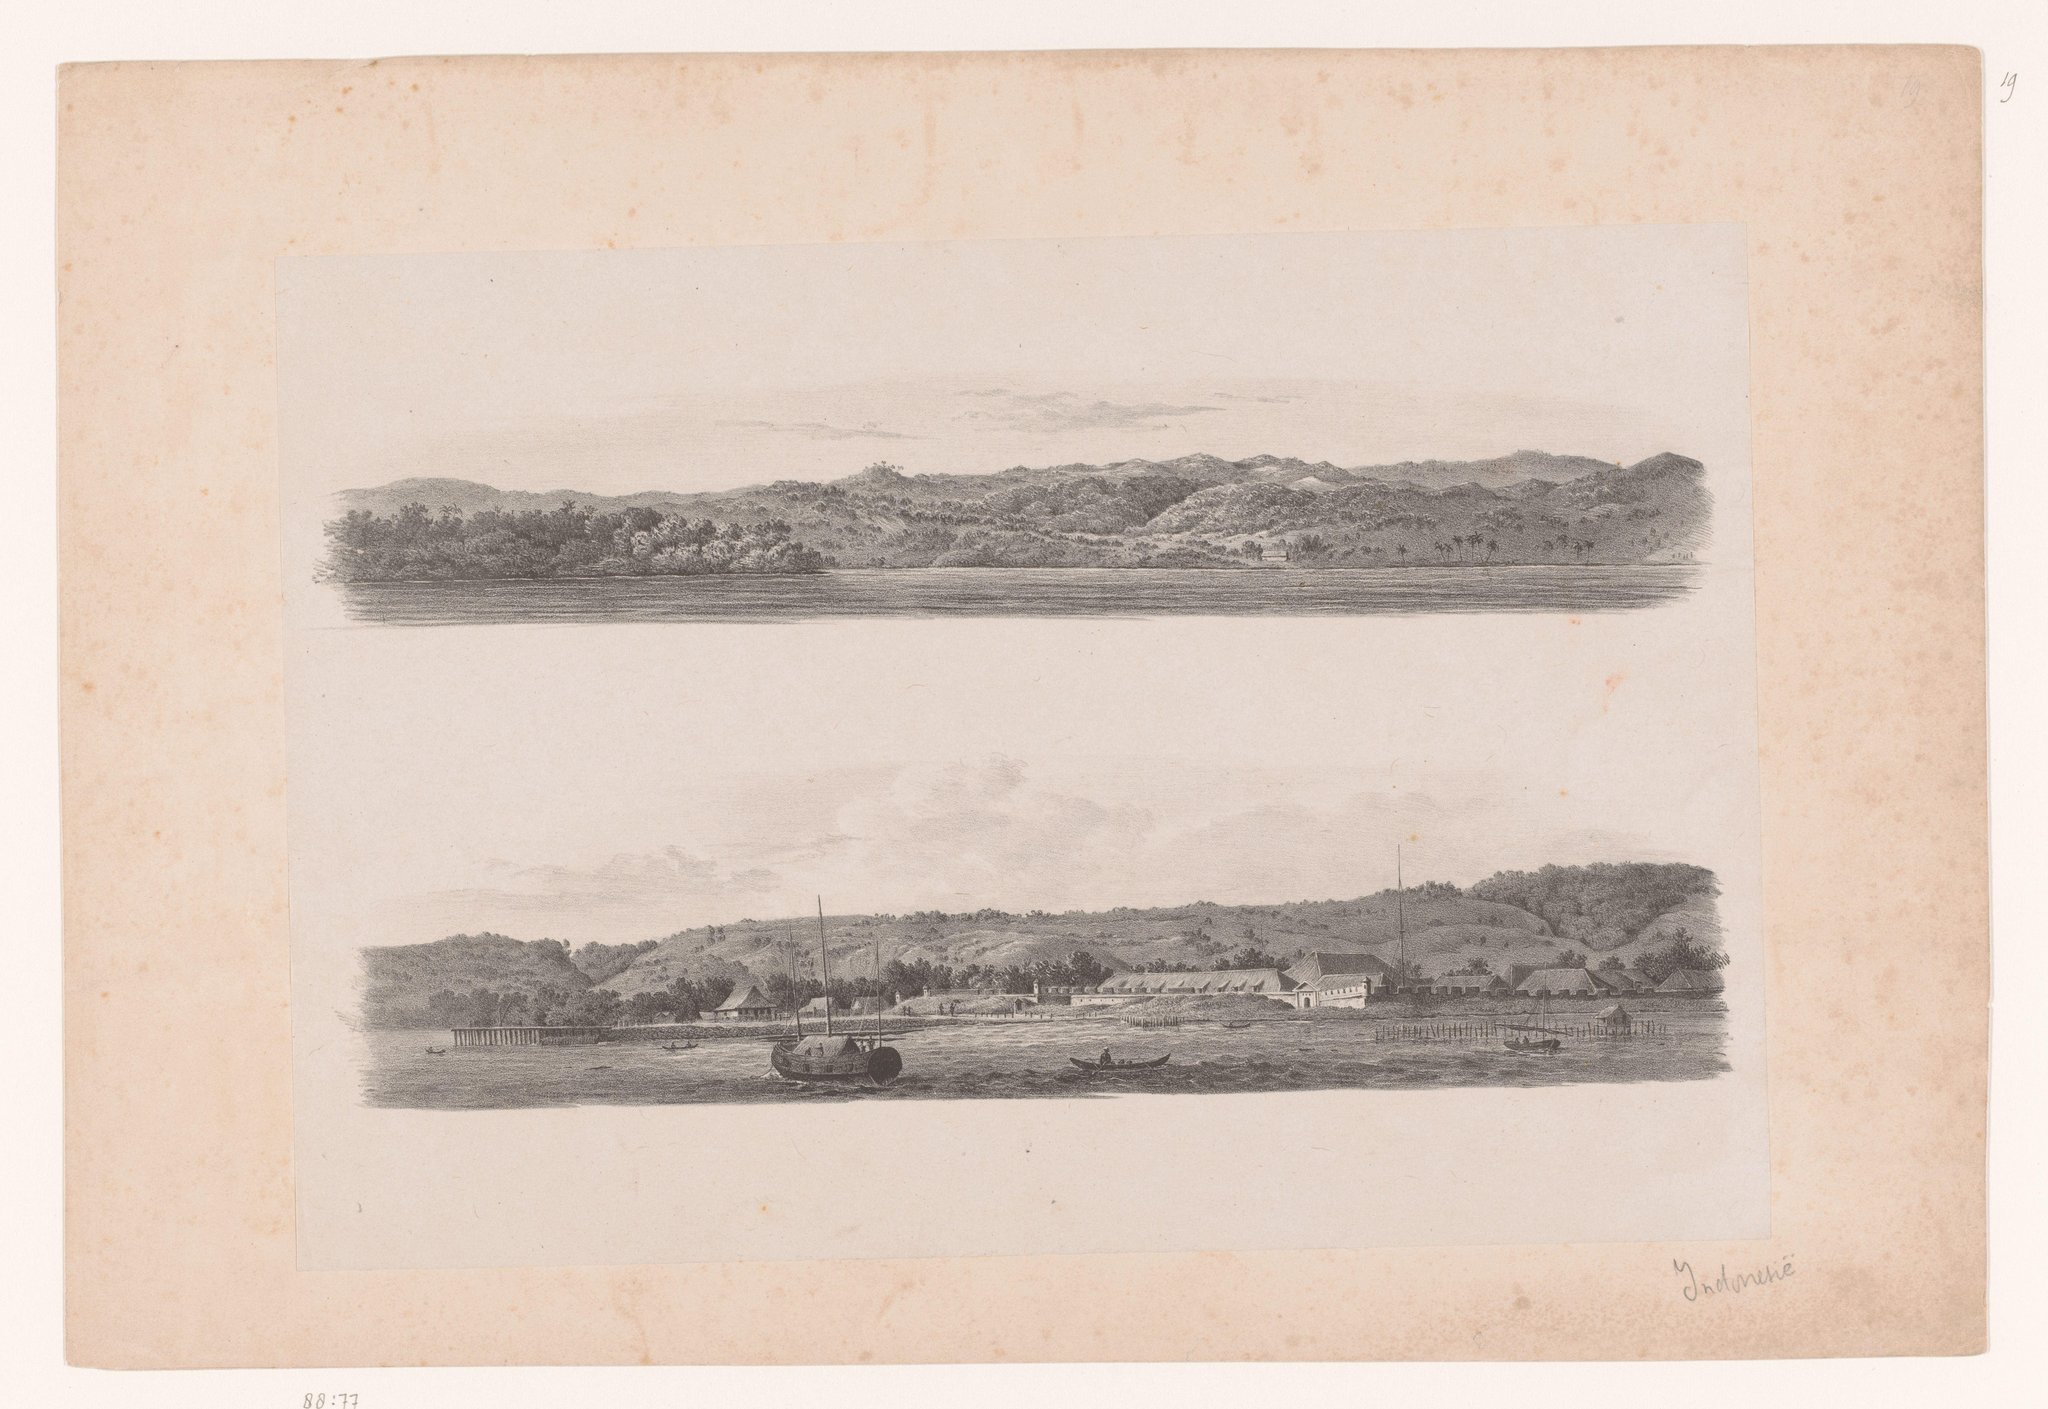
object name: print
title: Twee gezichten op Indonesische eilanden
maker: Anonymous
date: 1830-1880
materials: paper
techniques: lithograph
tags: fortress, island (in tropical and sub-tropical regions), indonesia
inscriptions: collector's mark: Lugt 2760, collector's mark: Lugt 2228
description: Twee gezichten, vanaf zee gezien, op eilanden in Indonesië. Op de onderste afbeelding een fort met daaromheen bouwwerken van de plaatselijke bevolking. Een aantal roeiboten en kleine zeilboten op het water.